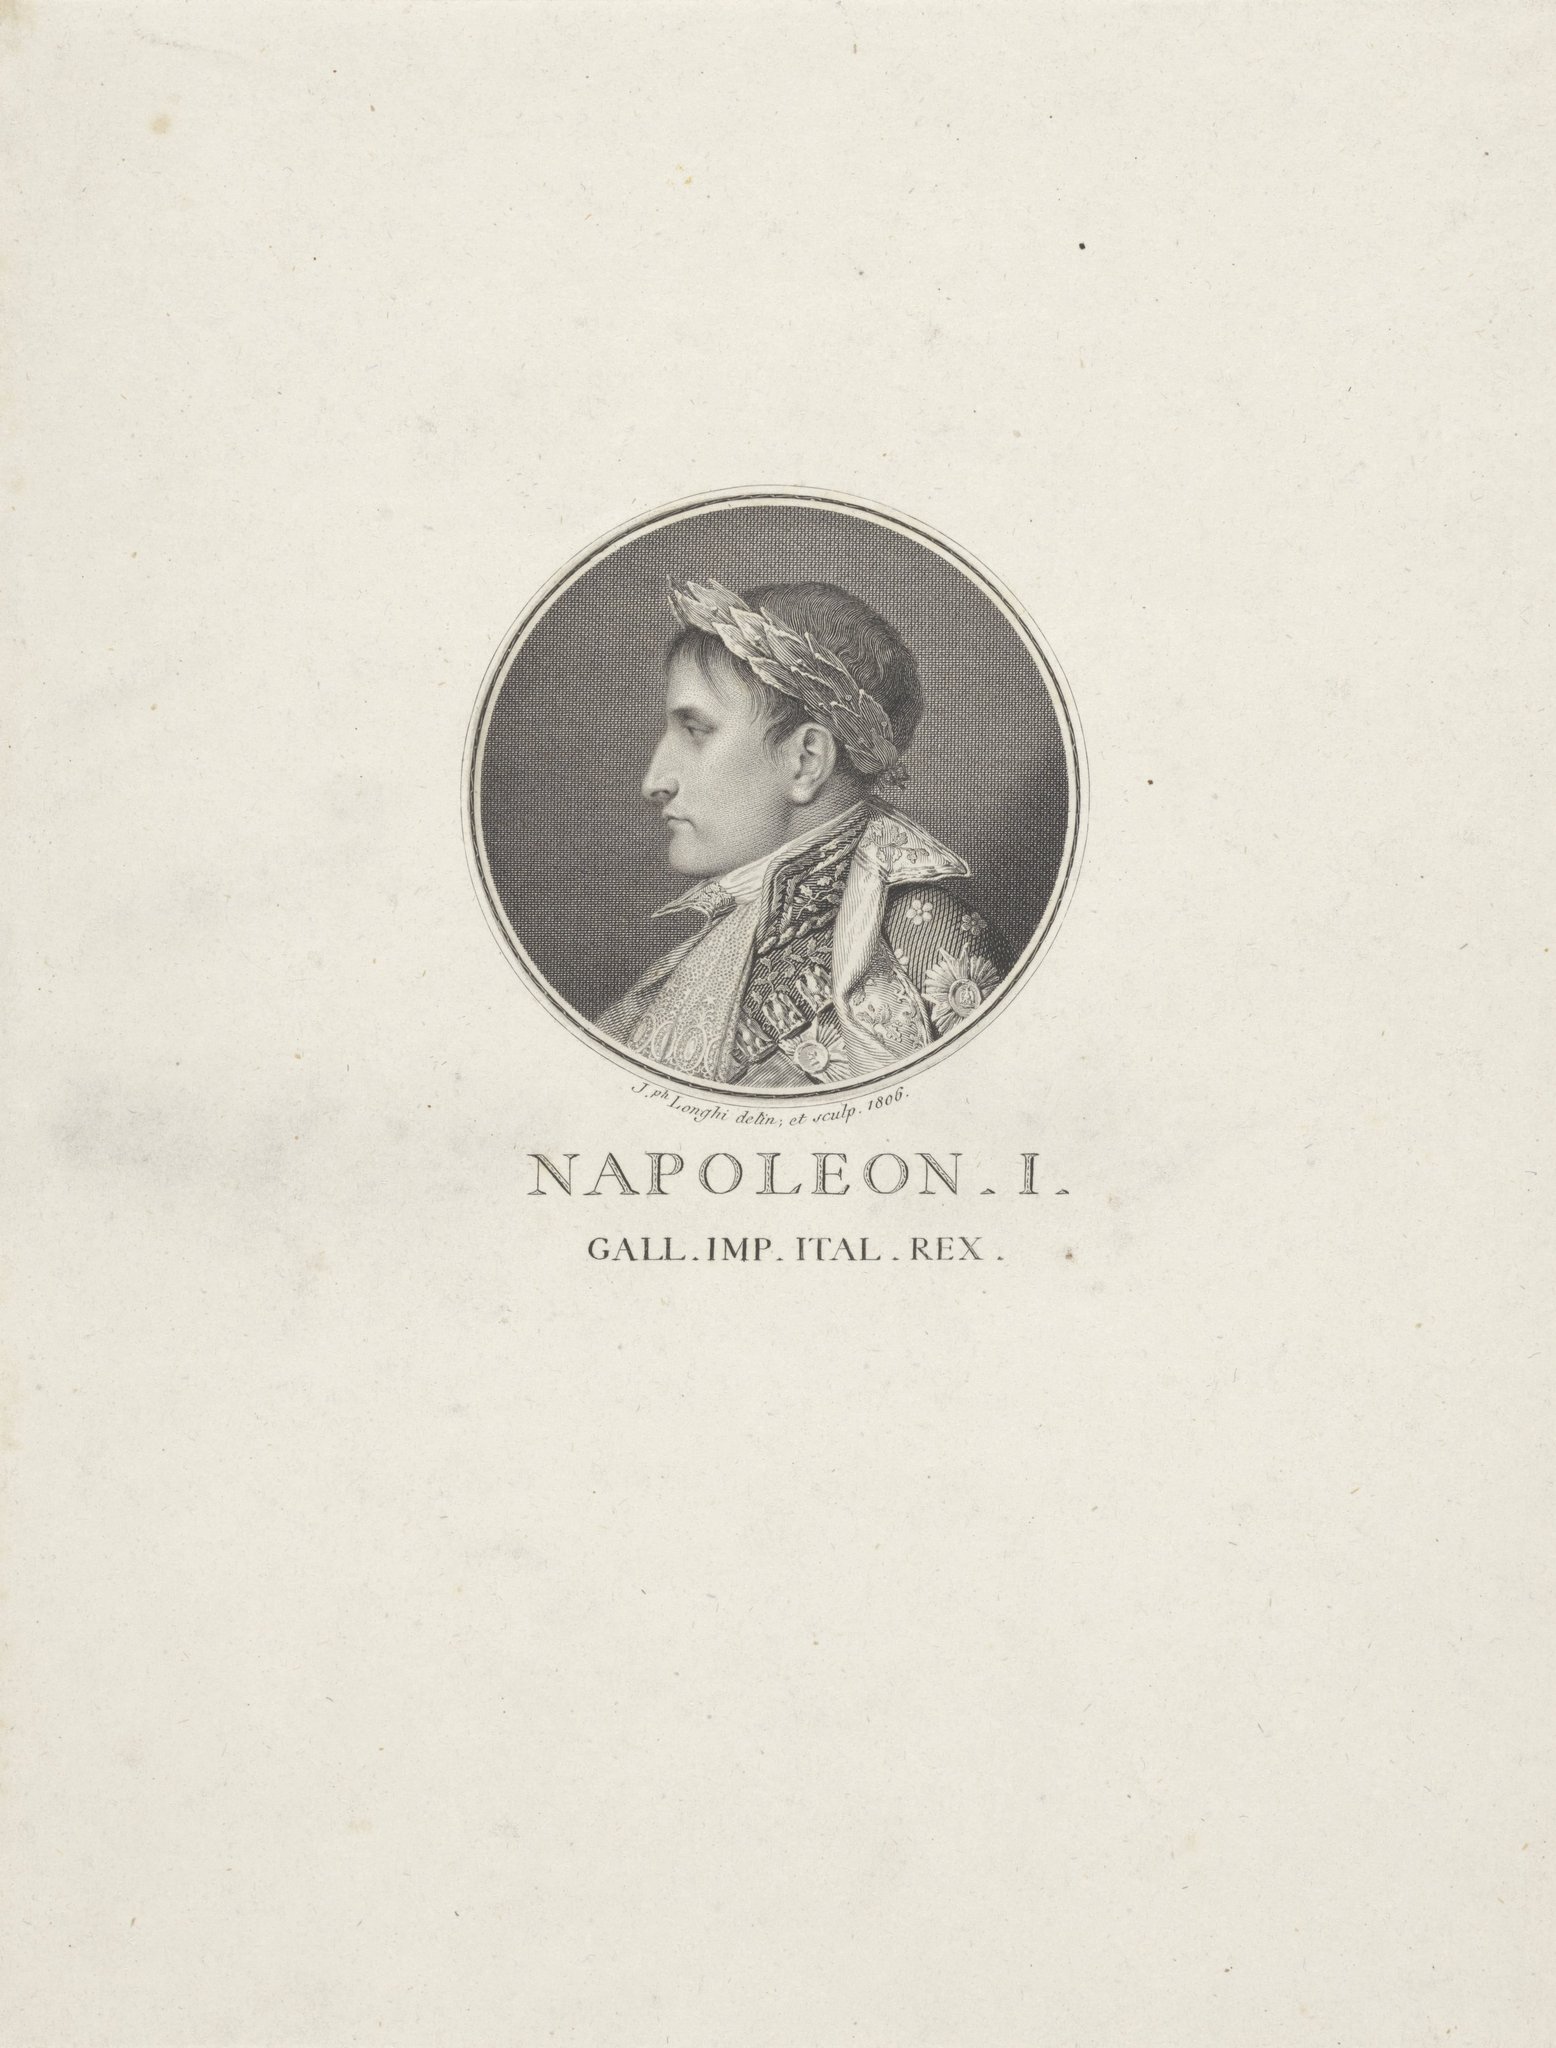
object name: print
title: Portret van Napoleon I Bonaparte, keizer der Fransen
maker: giuseppe longhi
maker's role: draughtsman, print maker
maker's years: 1766-1831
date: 1806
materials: paper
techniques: engraving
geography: italy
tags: napoleon i (emperor of the french), historical persons, ruler, sovereign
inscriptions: collector's mark: Lugt 12